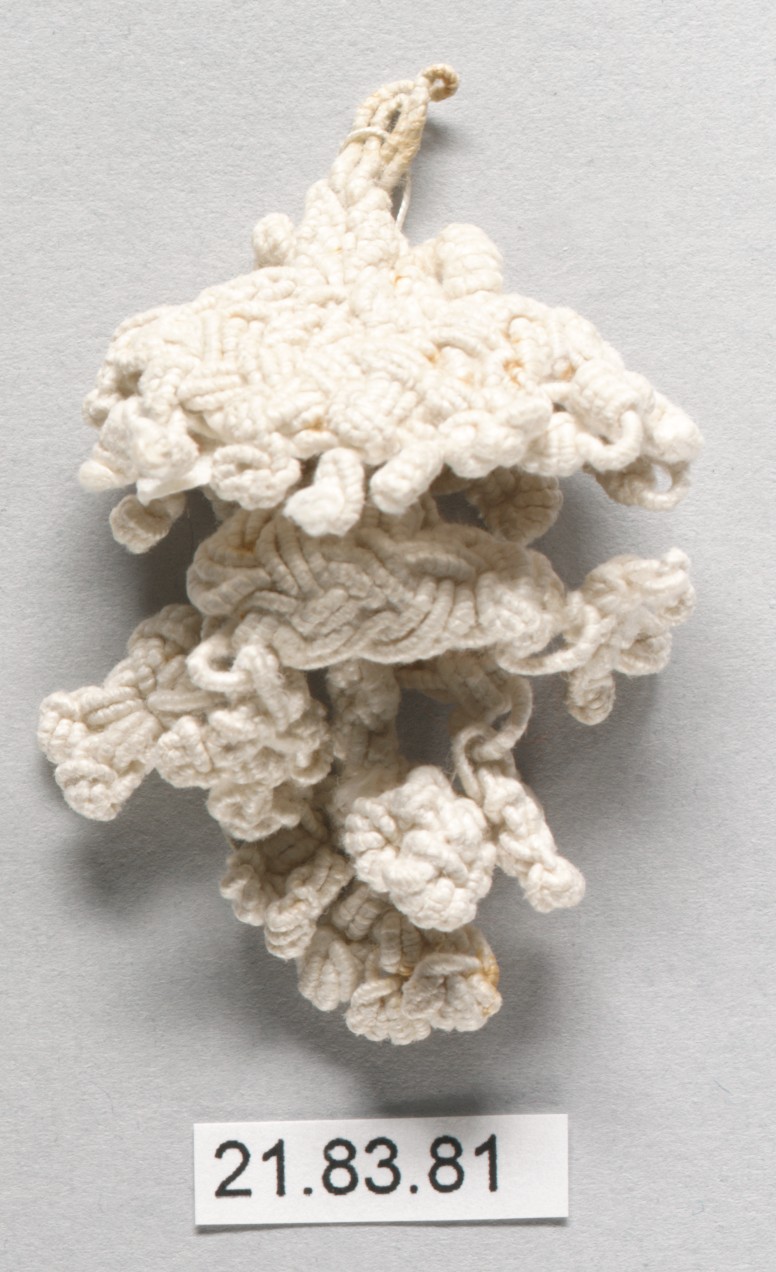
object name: tassel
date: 1601-1700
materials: linen